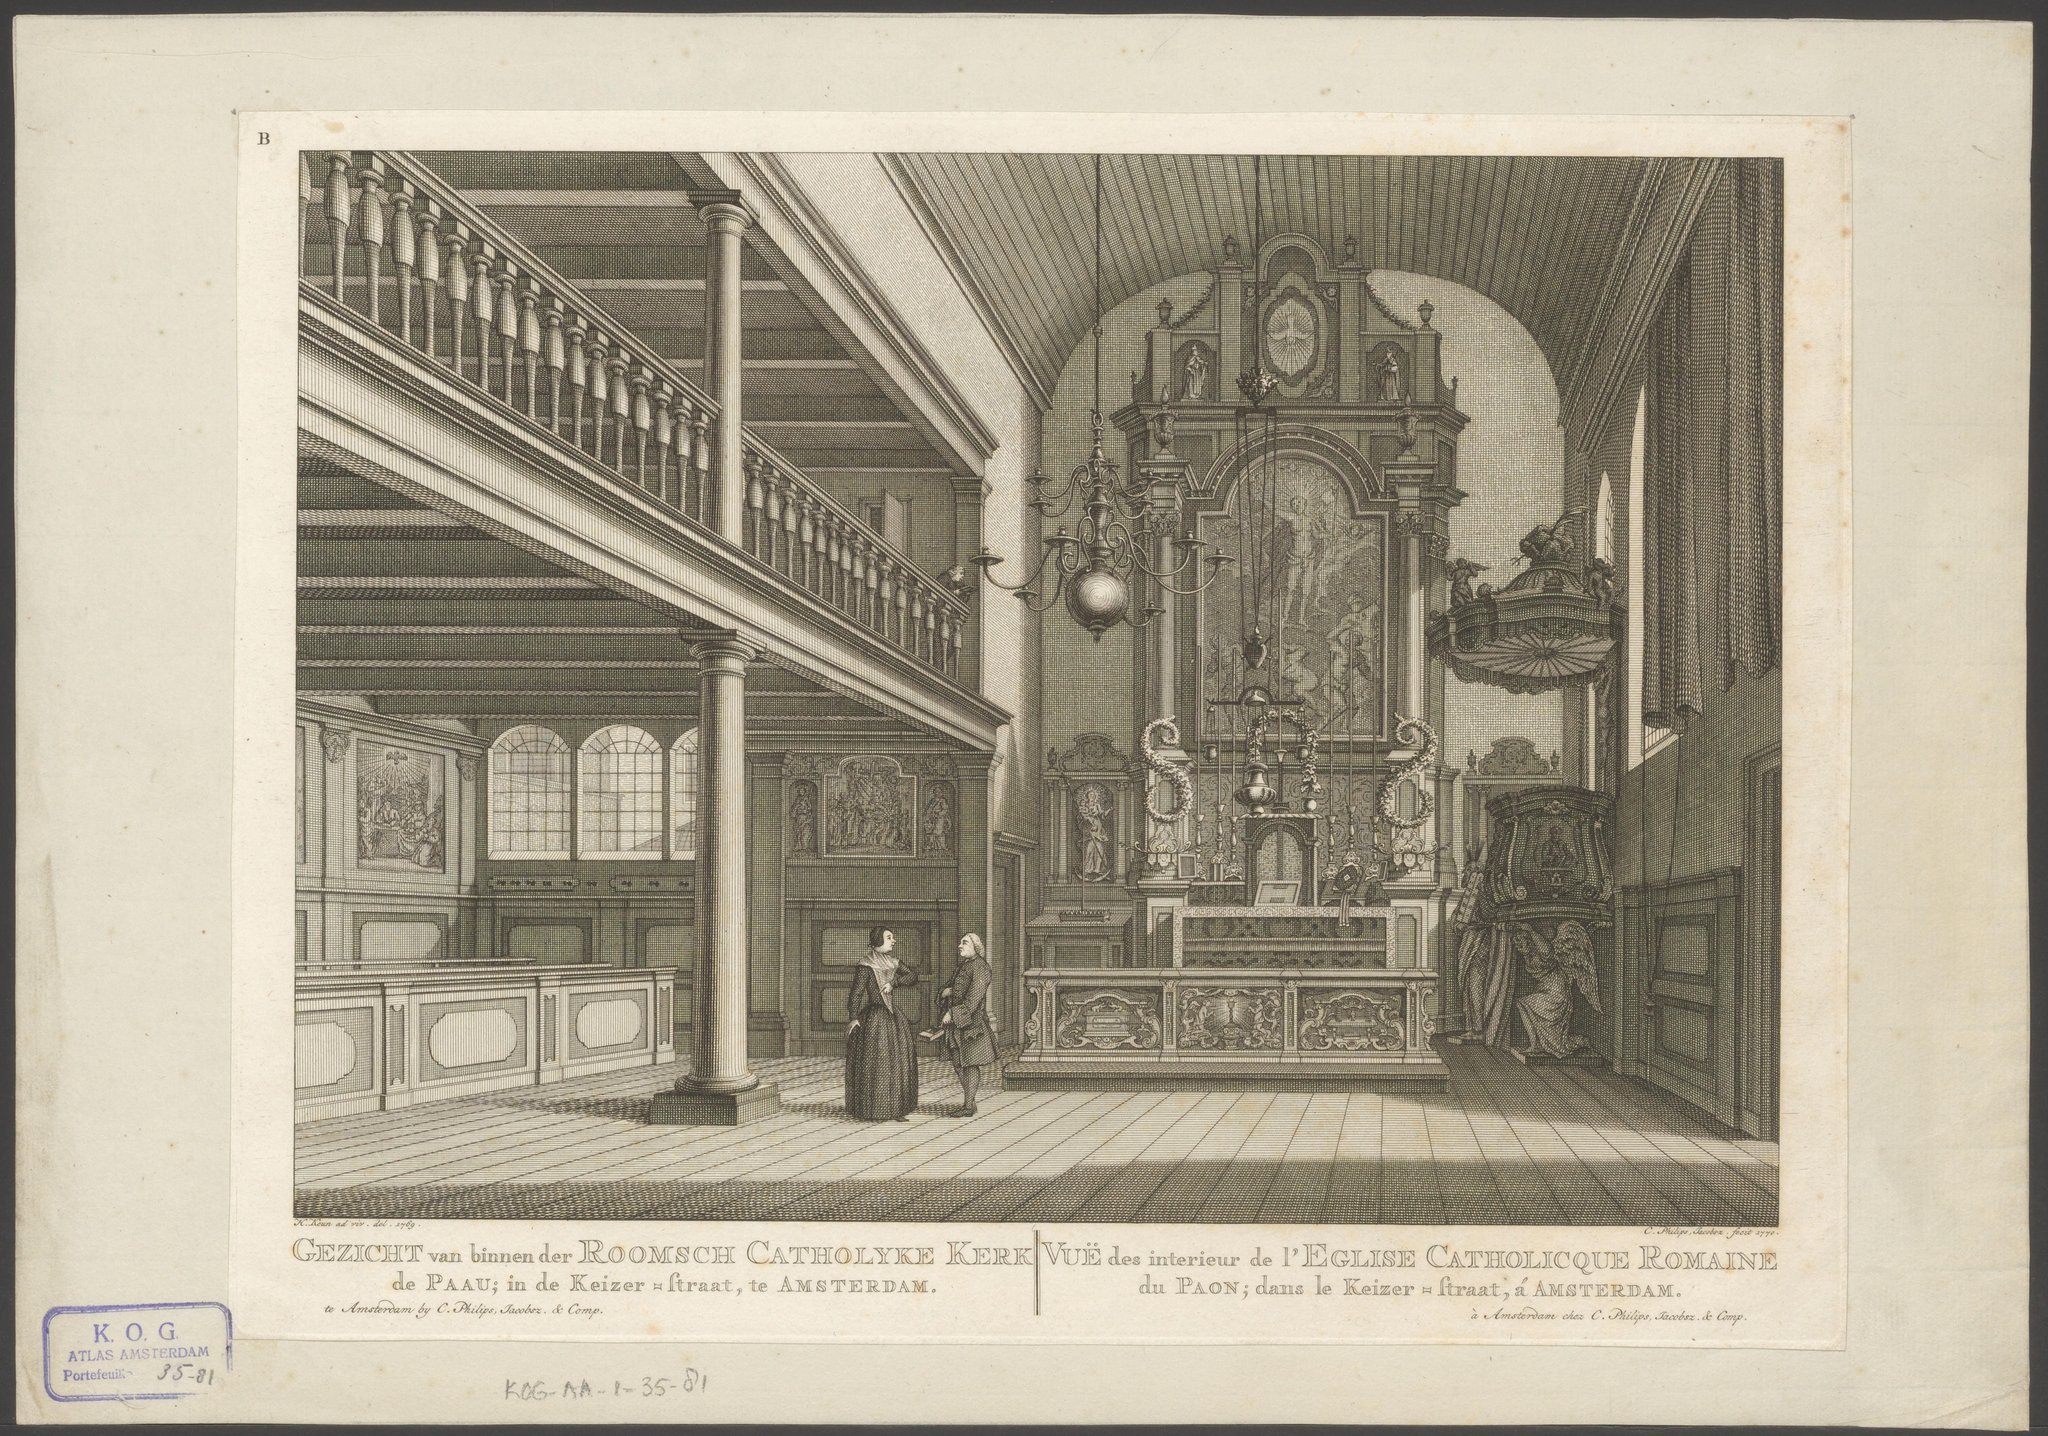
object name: print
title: Vuë des interieur de l'Eglise Catholicque Romaine du Paon; dans le Keizer-straat, á Amsterdam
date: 1770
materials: paper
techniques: engraving, etching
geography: amsterdam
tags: interior of church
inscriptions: collector's mark: ‘35-81’ Lugt 1641b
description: Linksboven genummerd: B. Onderwerpsrubriek binnen de Atlas Amsterdam: R.K. Gemeenten: oud-bisschoppelijke Clerezie.